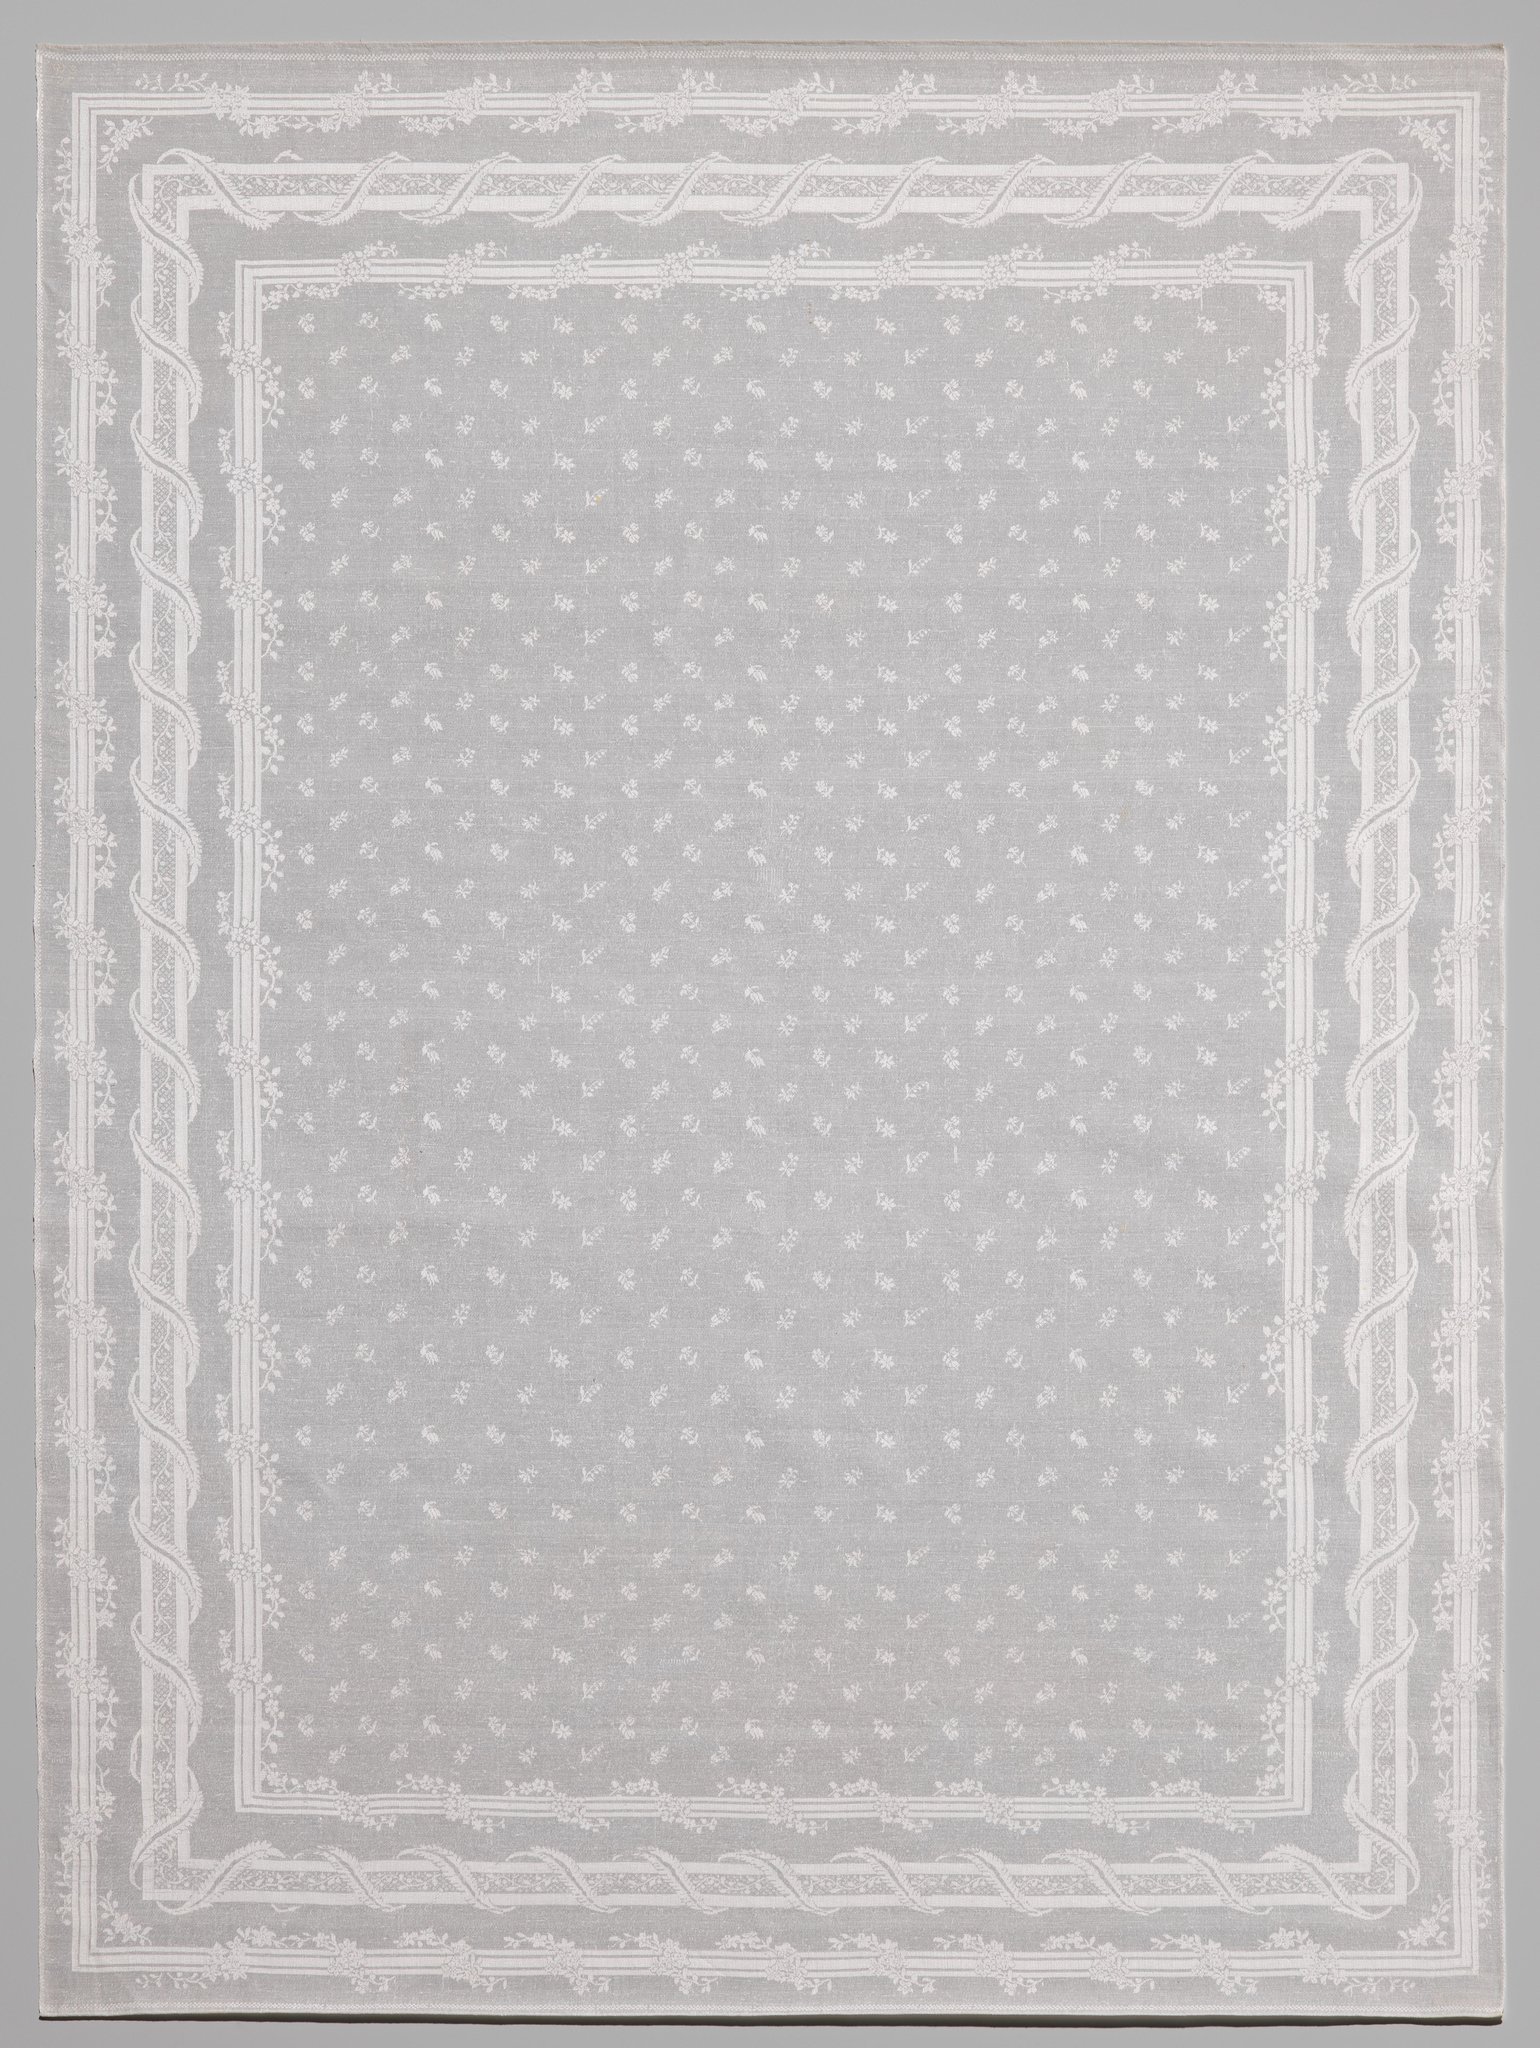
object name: napkin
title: Servet van wit linnendamast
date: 1775-1816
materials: linen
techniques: damask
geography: netherlands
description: Wit linnendamasten servet met een patroon van een gestrooid fijn bloemtakje, merk WS 36.